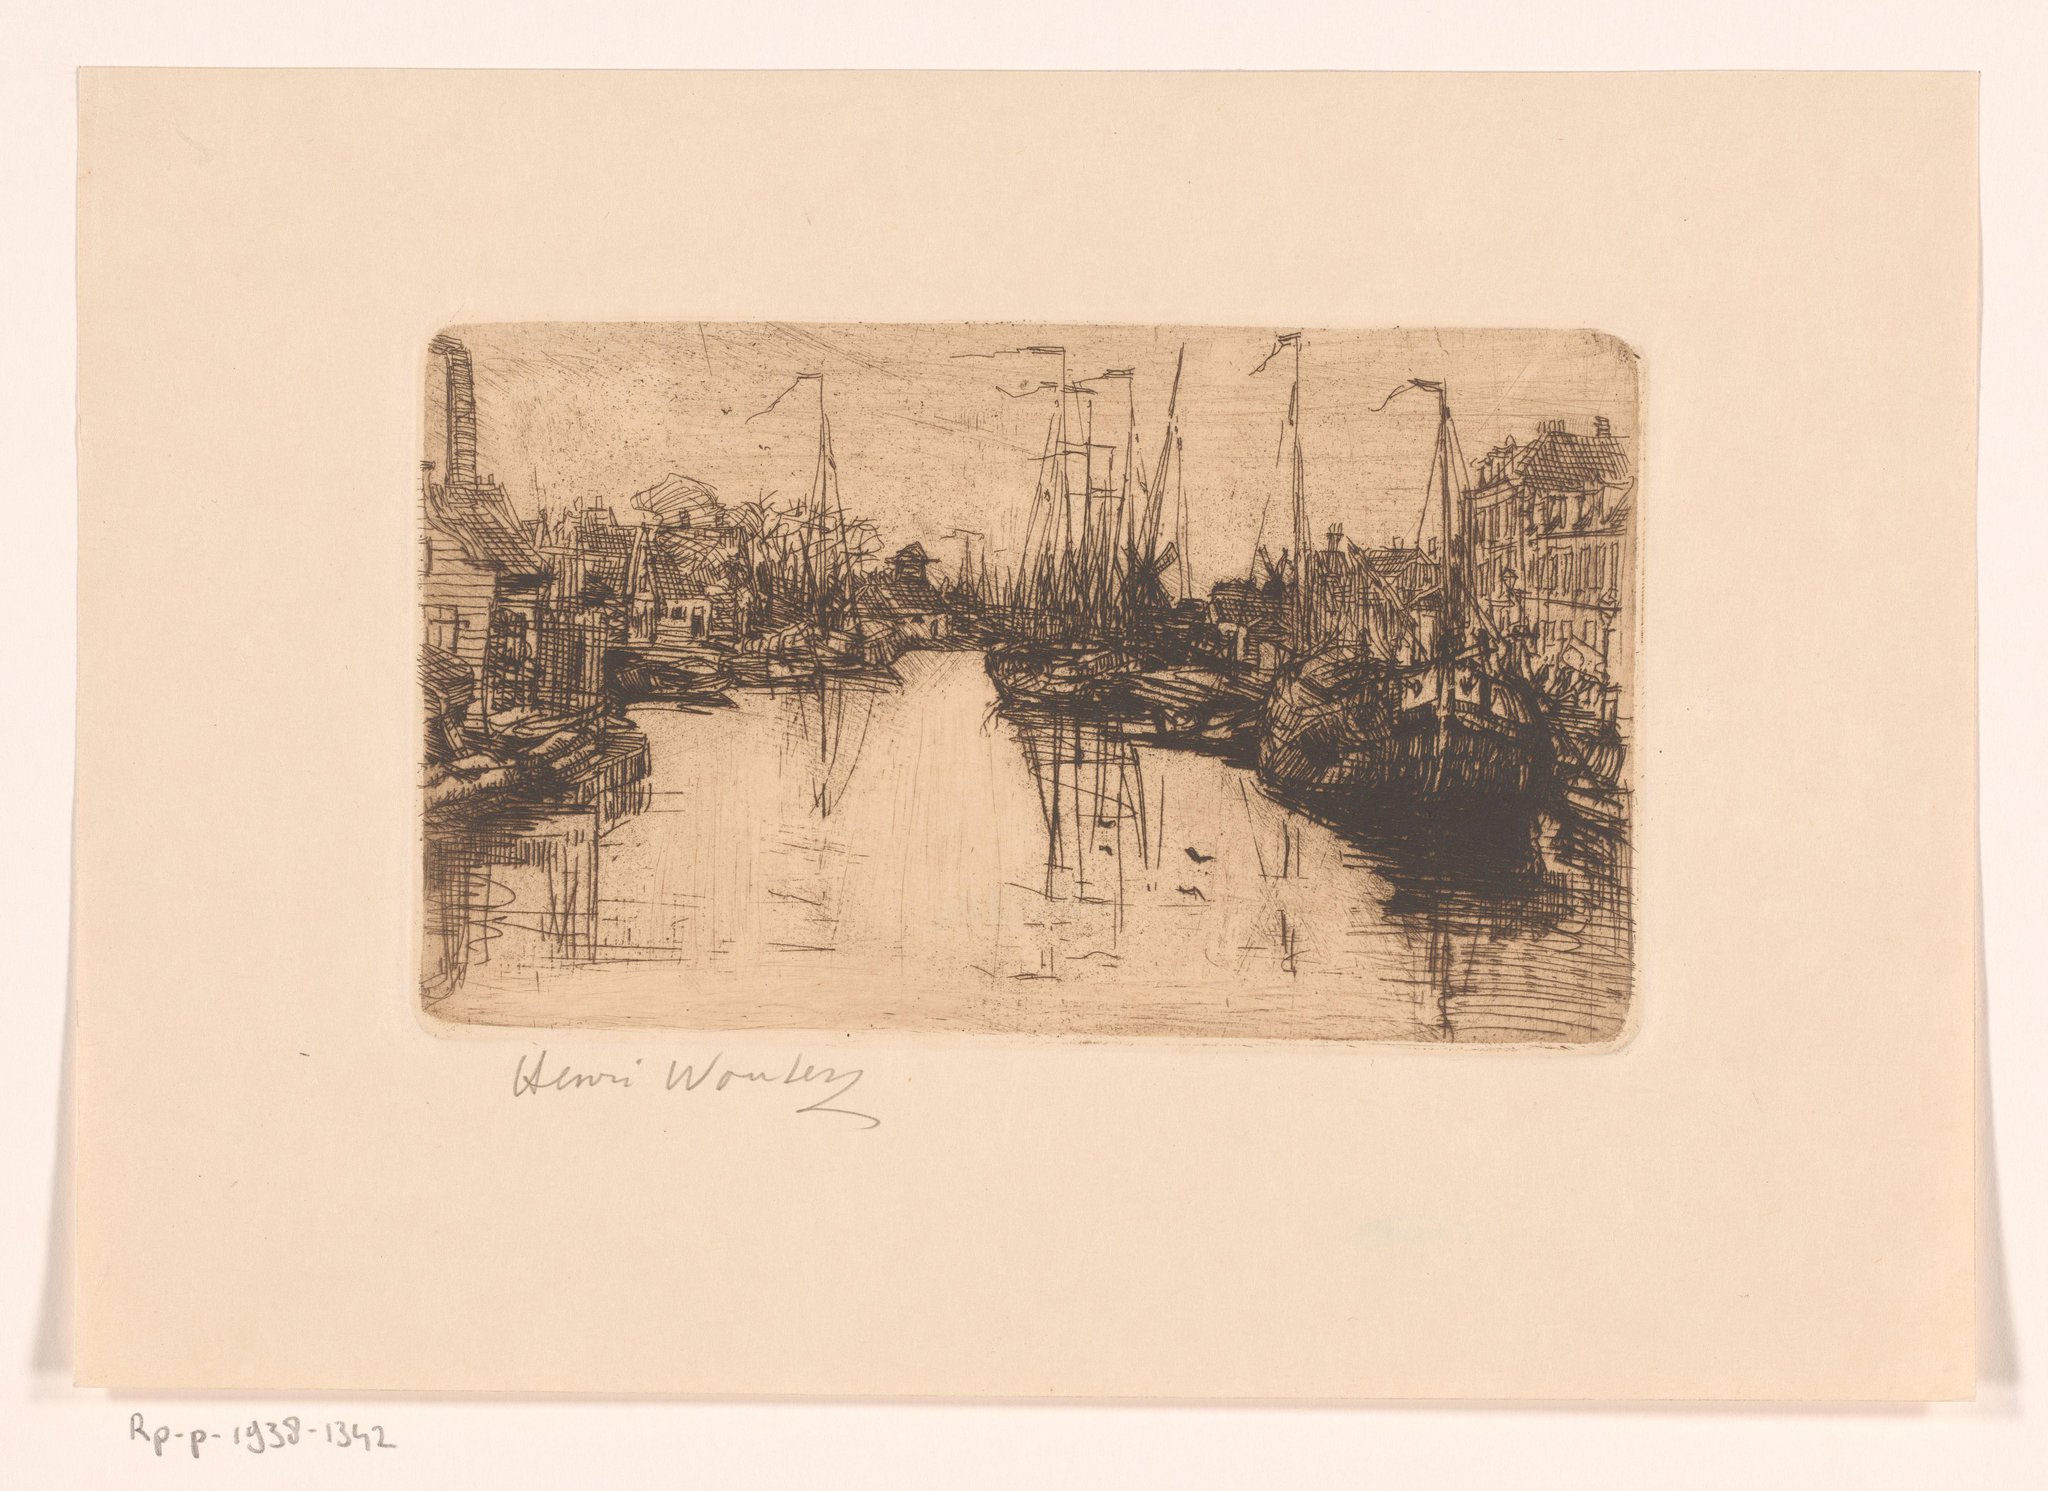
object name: print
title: Stadsgracht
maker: henri wouters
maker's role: draughtsman, print maker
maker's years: 1866-1935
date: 1876-1918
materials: paper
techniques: drypoint, etching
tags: canal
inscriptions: collector's mark: Lugt 2760, collector's mark: Lugt 2228